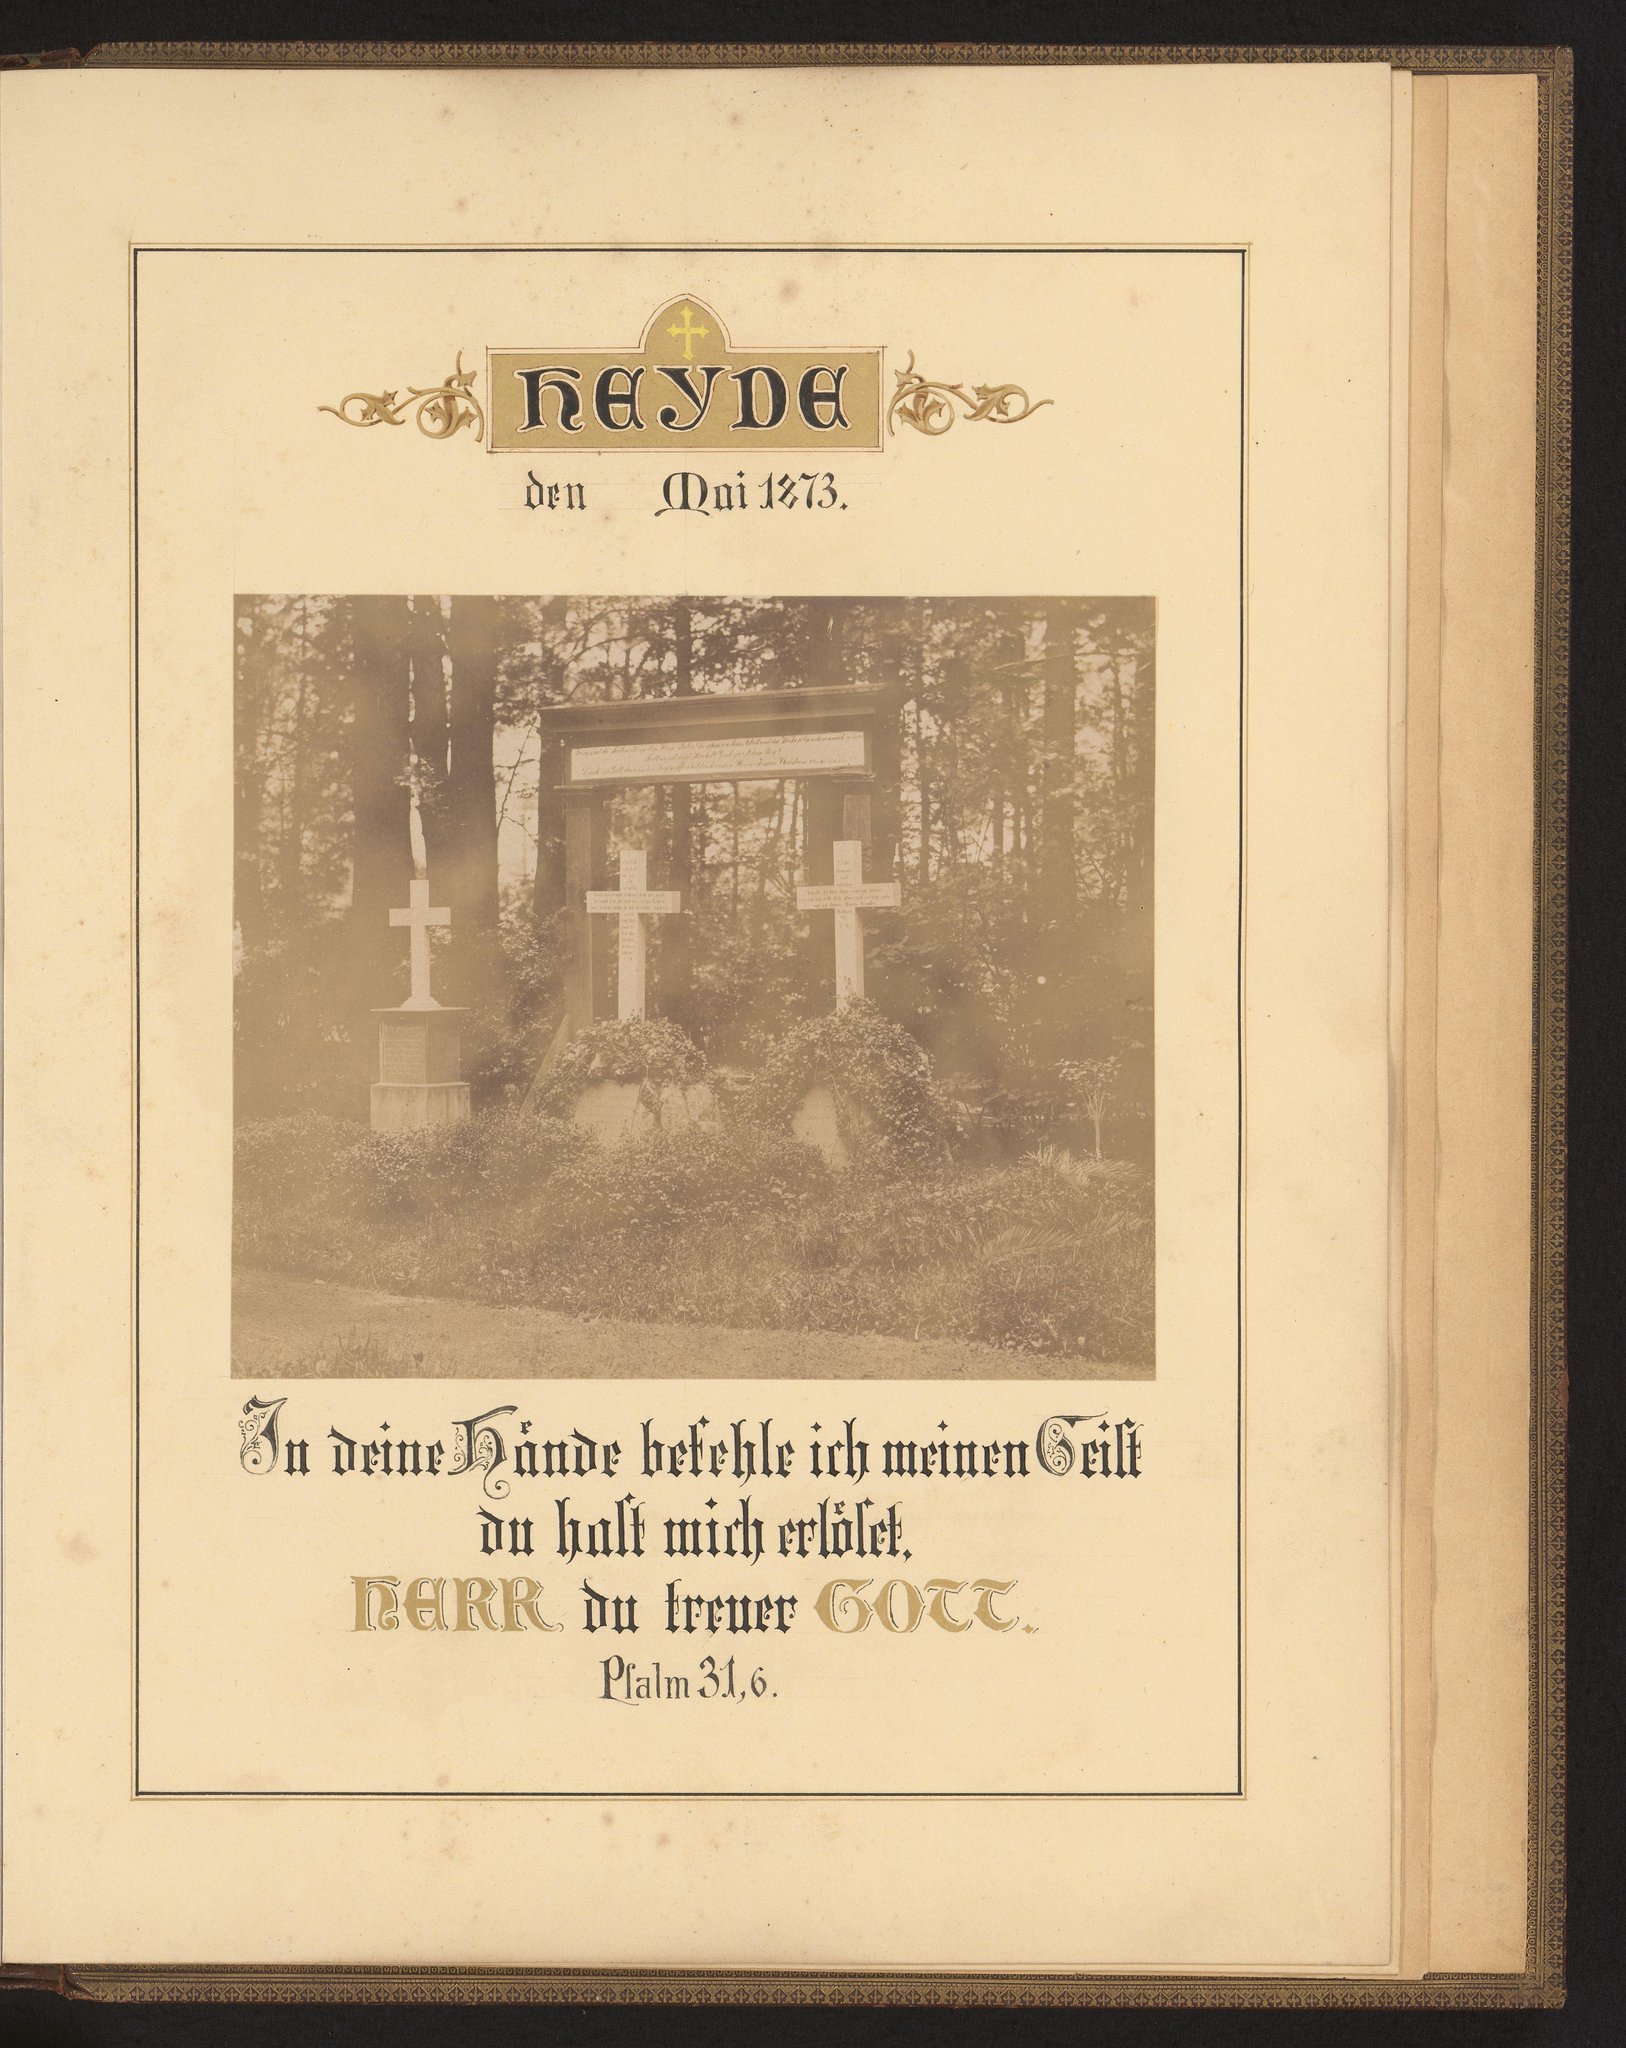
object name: album leaf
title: Grafmonument met drie kruizen ter nagedachtenis aan Carl von Bodelschwingh, bij Haus Heyde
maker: Anonymous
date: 1873-1875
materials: paper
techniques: albumen print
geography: haus heyde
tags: berlin, politician, grave, tomb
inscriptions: inscription: ‘In deine Hände befehle ich meinen Geist/ du hast mich erlöset,/ HERR du treuer GOTT./ Psalm 31, 6.’